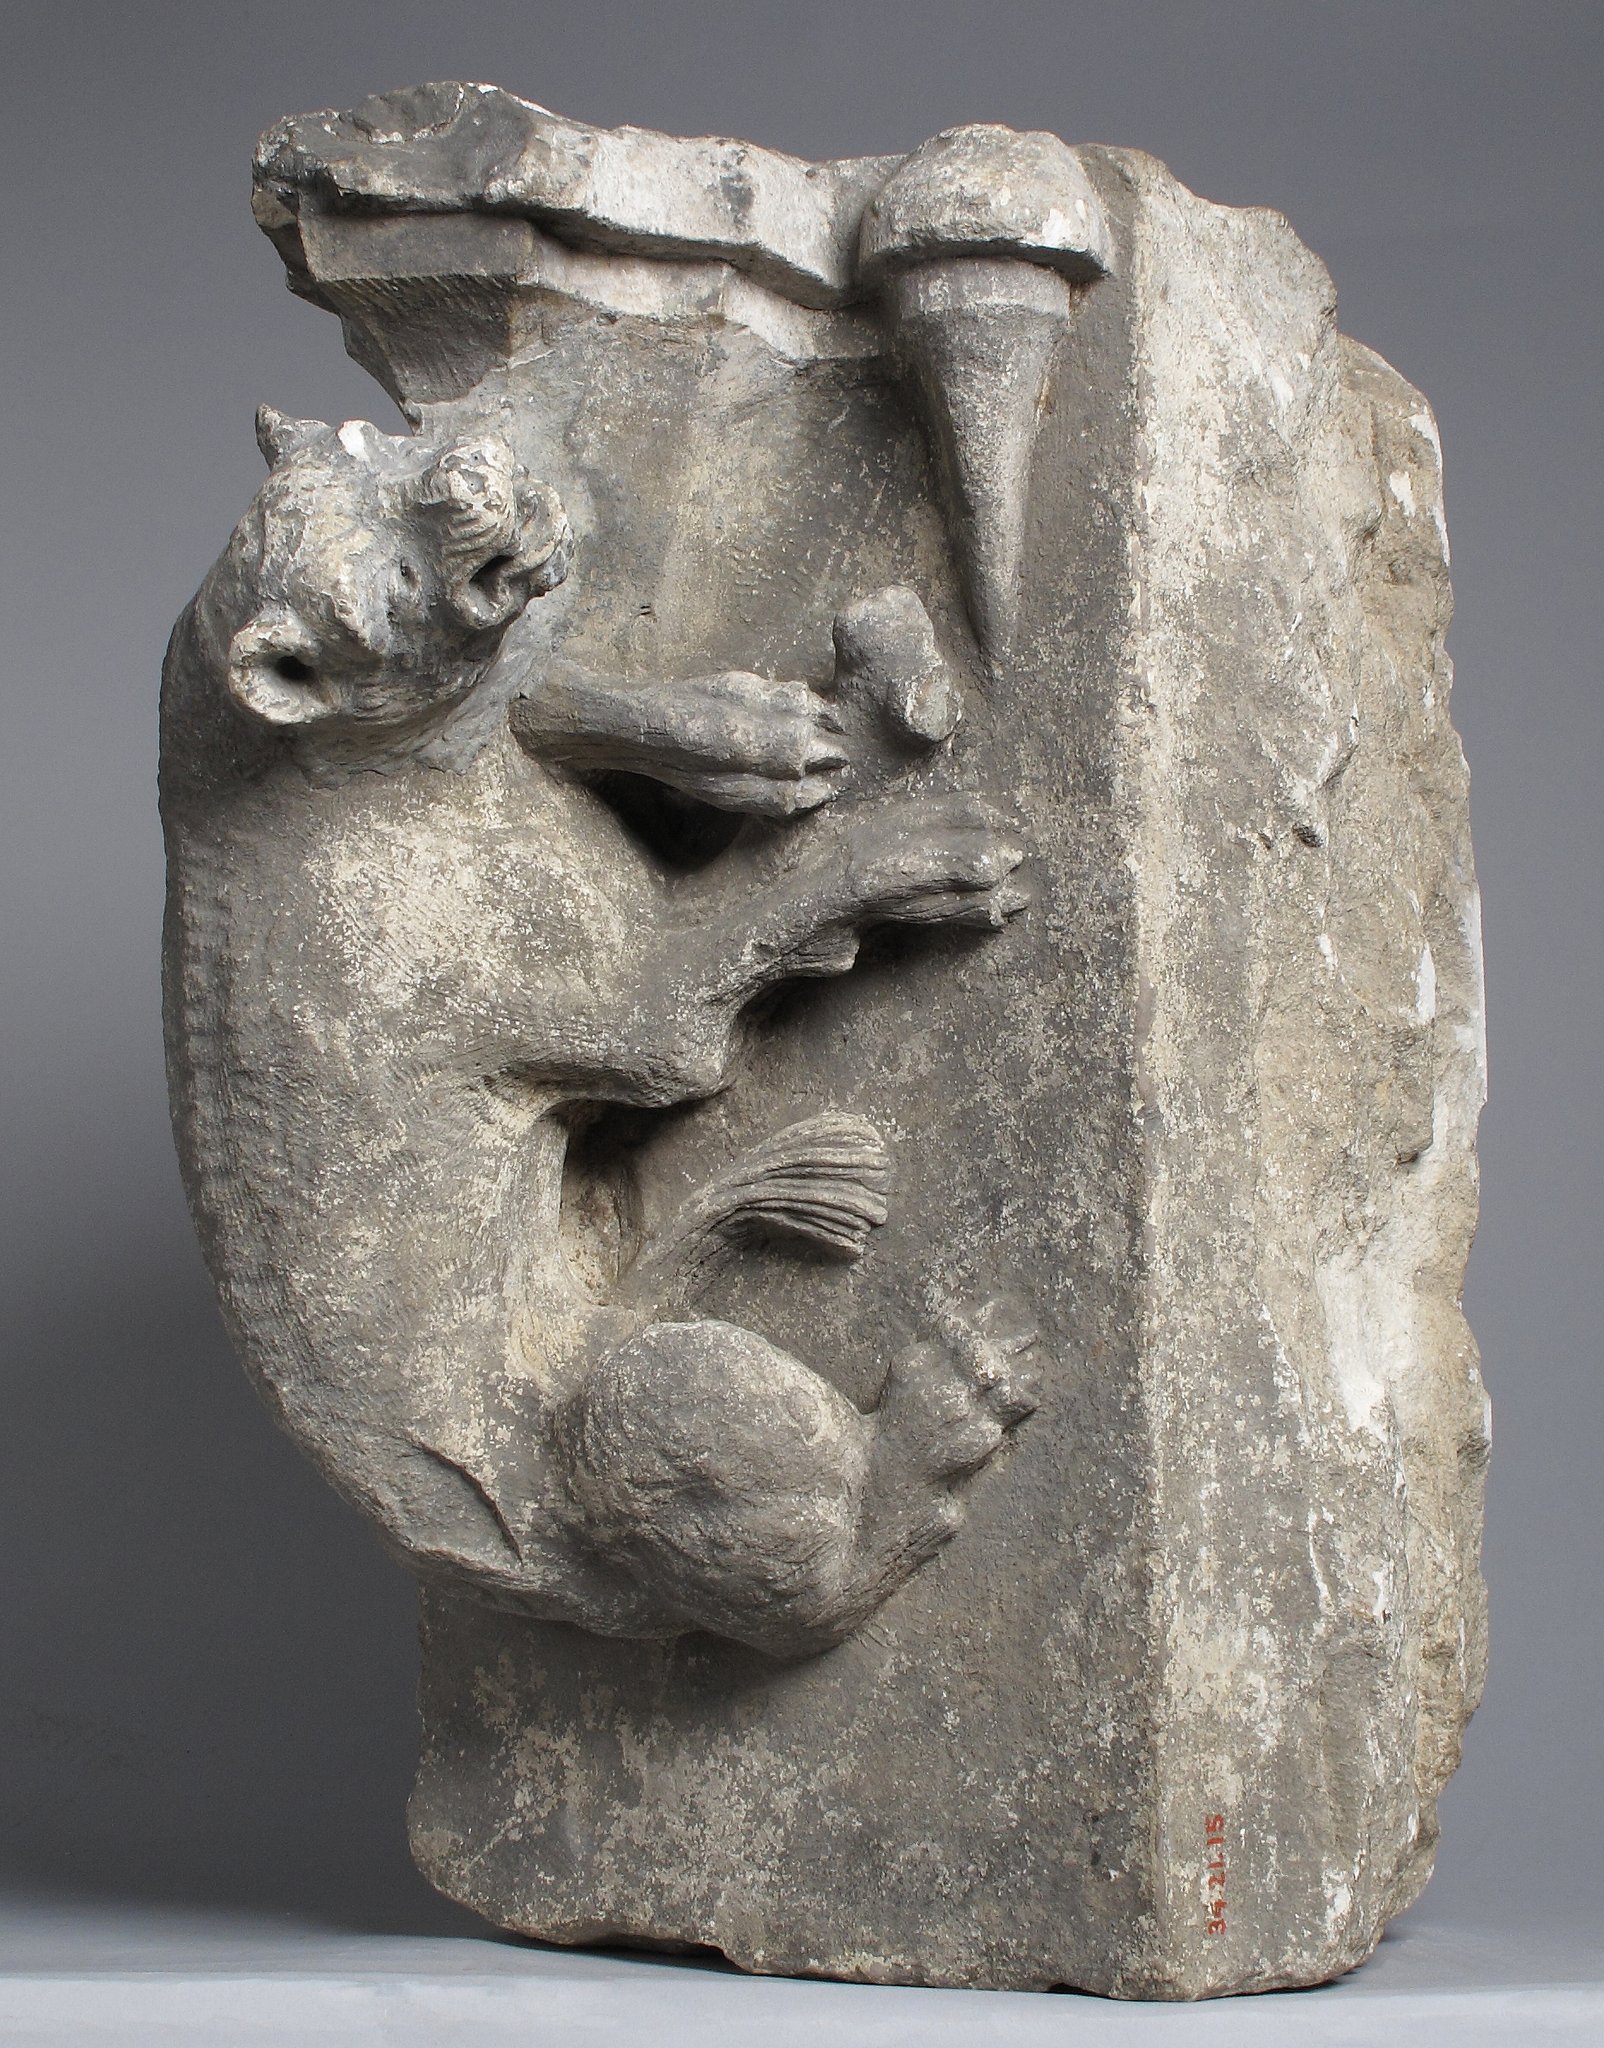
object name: corbel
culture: french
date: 1401-1500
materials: stone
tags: animals